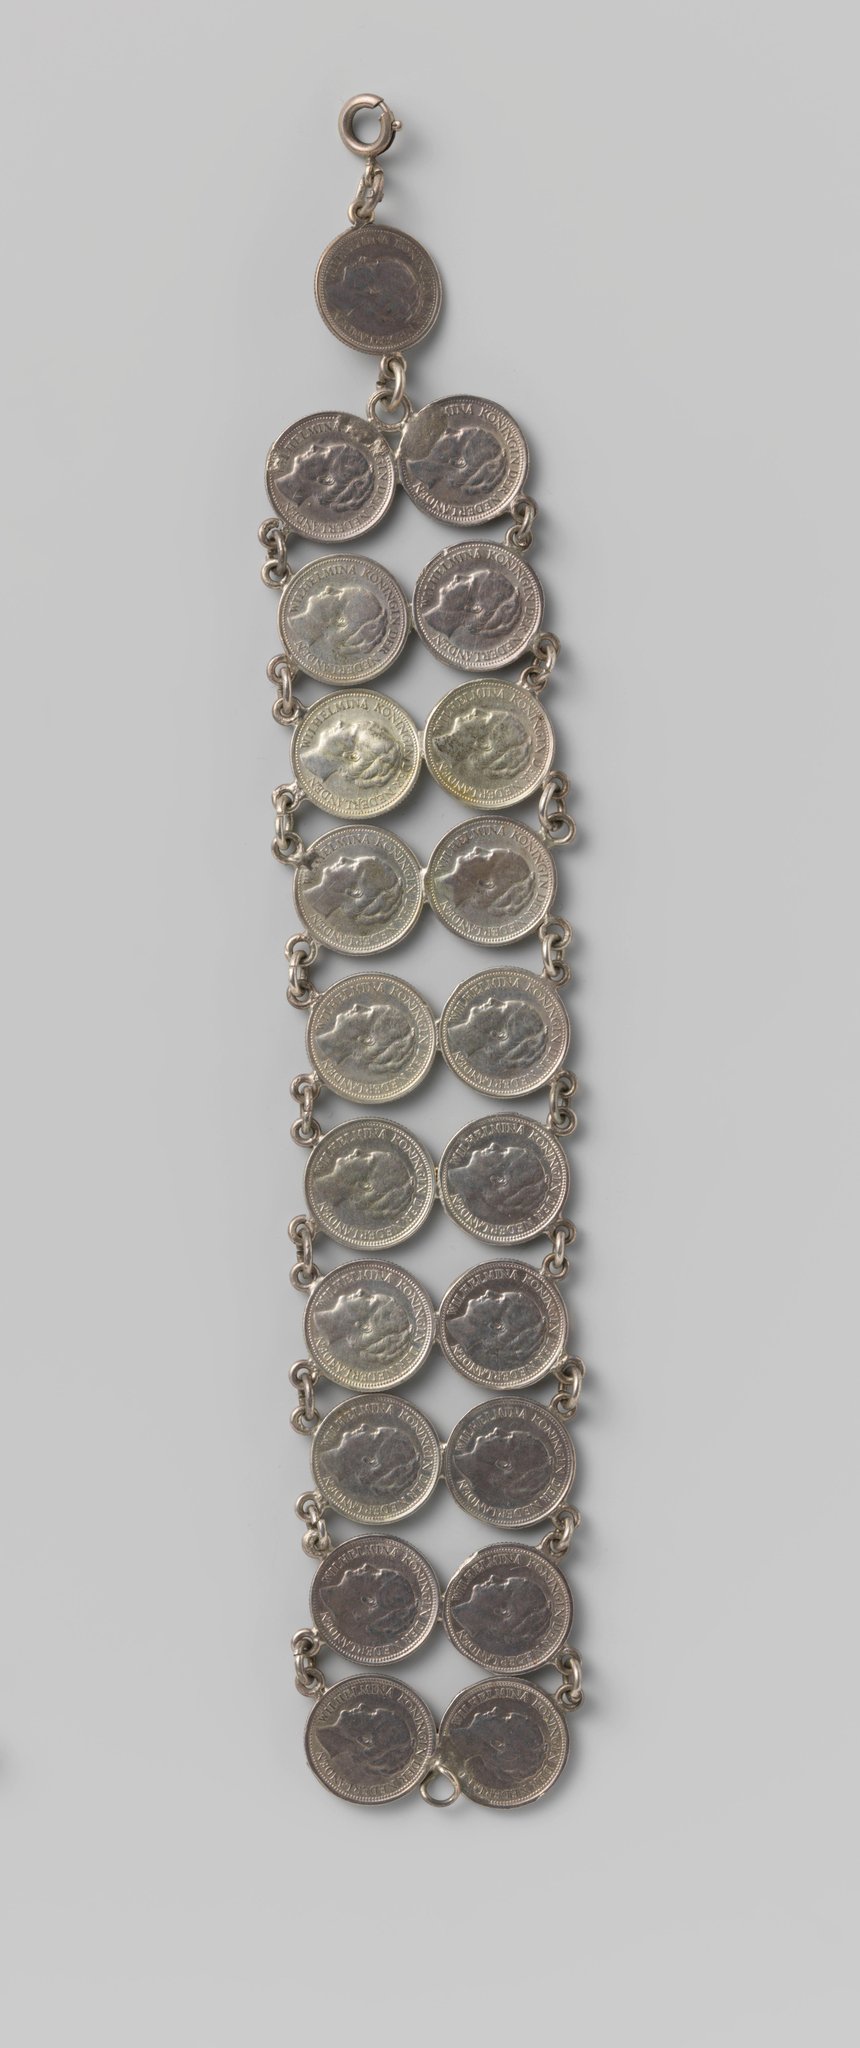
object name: bracelet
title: Armband van twee rijen zilveren dubbeltjes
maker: Anonymous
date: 1940-1950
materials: silver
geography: netherlands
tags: the hague, print maker, wilhelmina of the netherlands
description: Armband van twee rijen zilveren dubbeltjes. Voor de haak verjongt de armband zich tot één dubbeltje. In totaal bestaat de armband uit eenentwintig dubbeltjes met het portret van Wilhelmina.